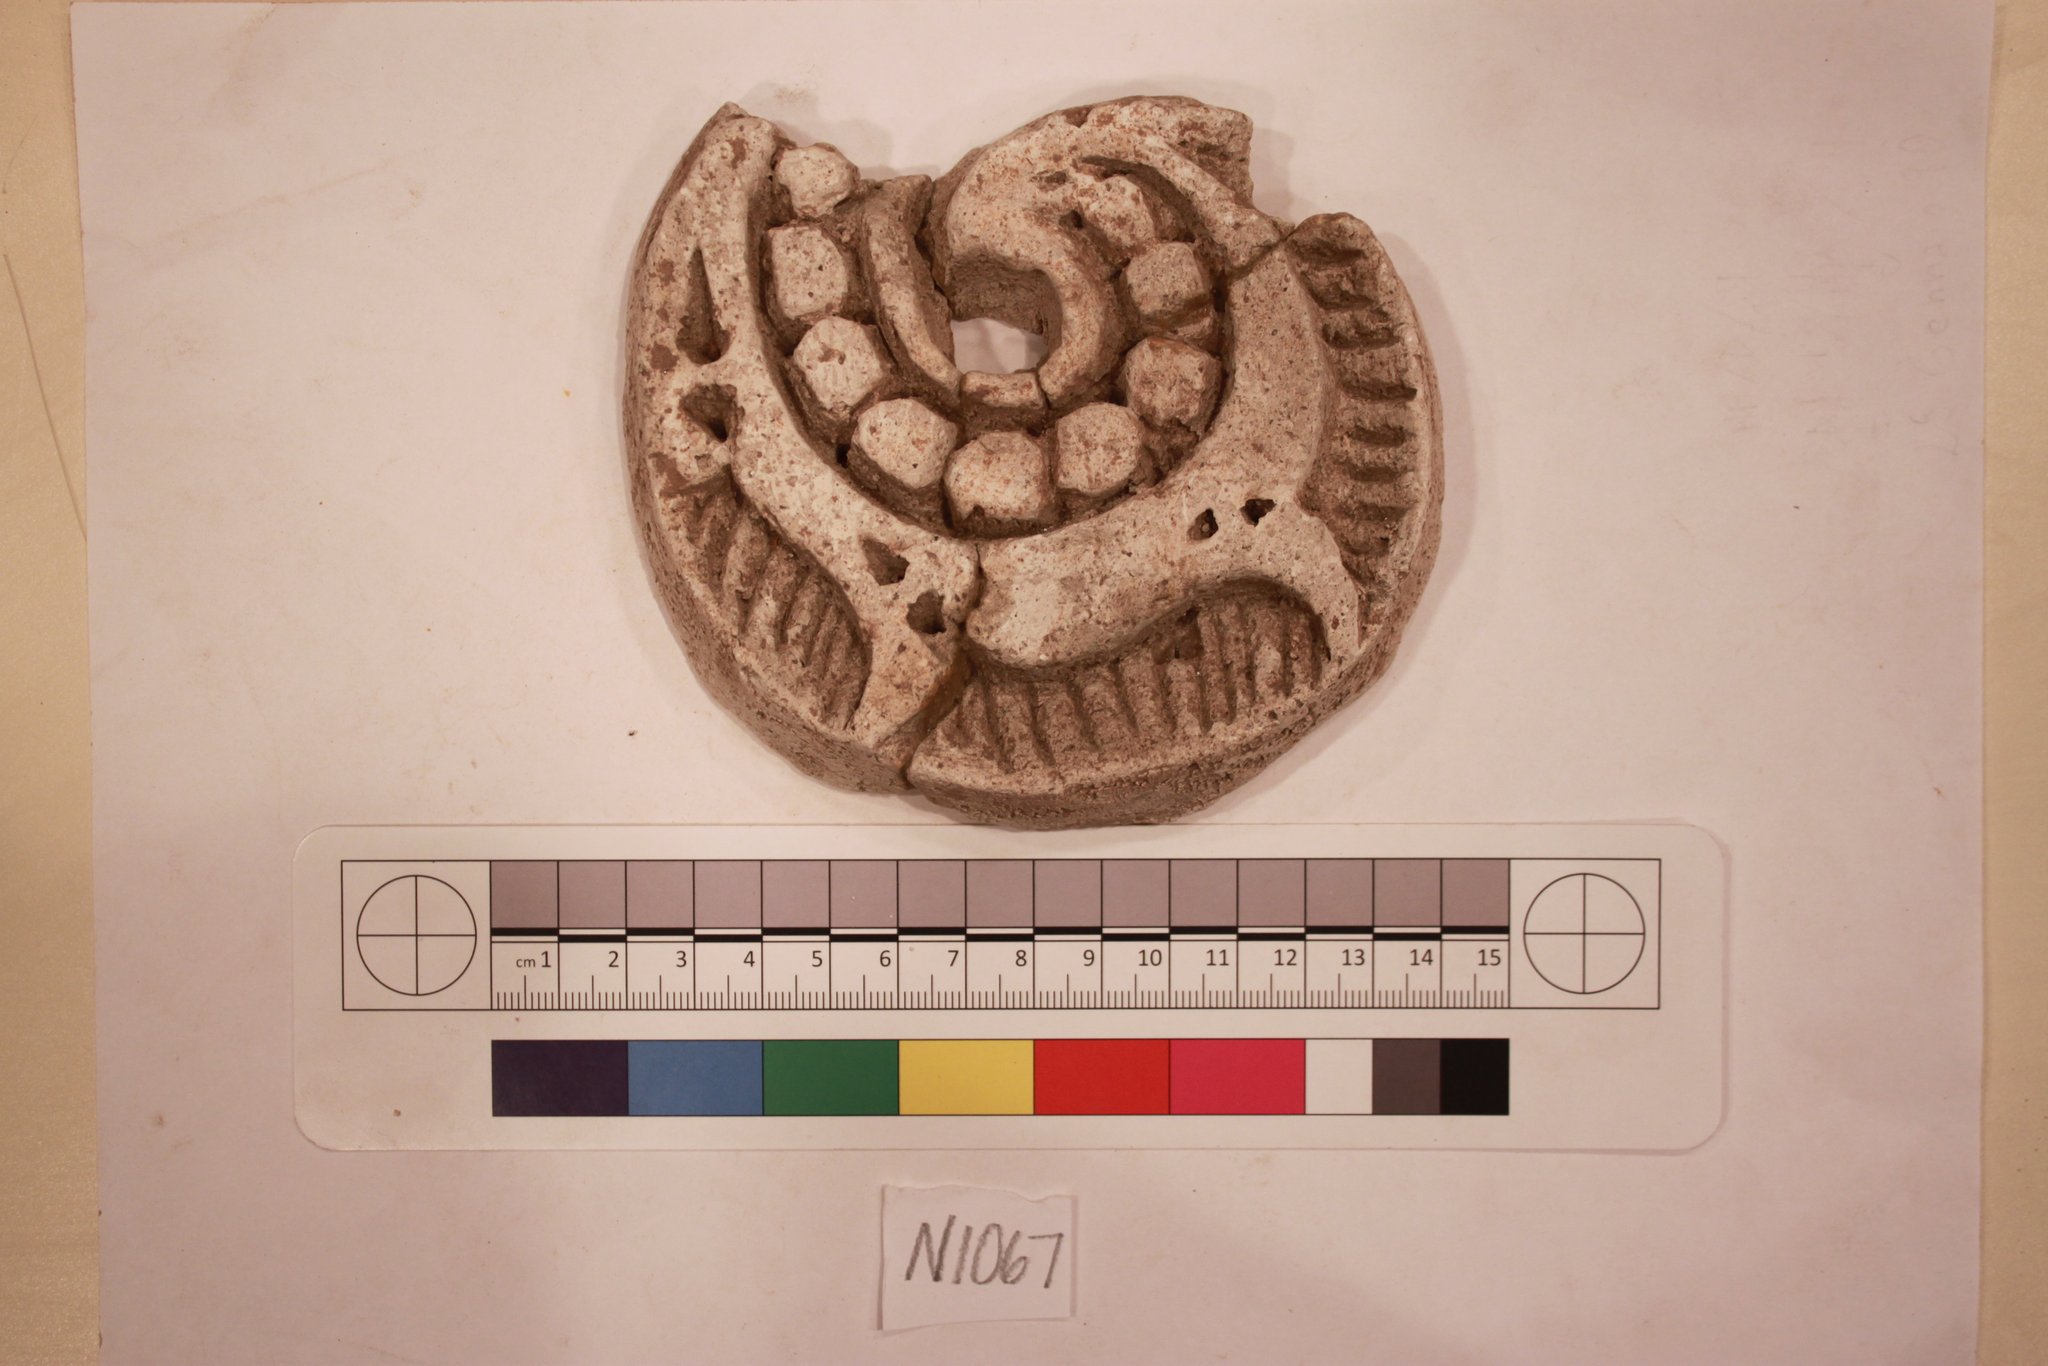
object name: fragment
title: Stucco Fragment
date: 701-1200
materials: plaster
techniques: carving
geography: iran